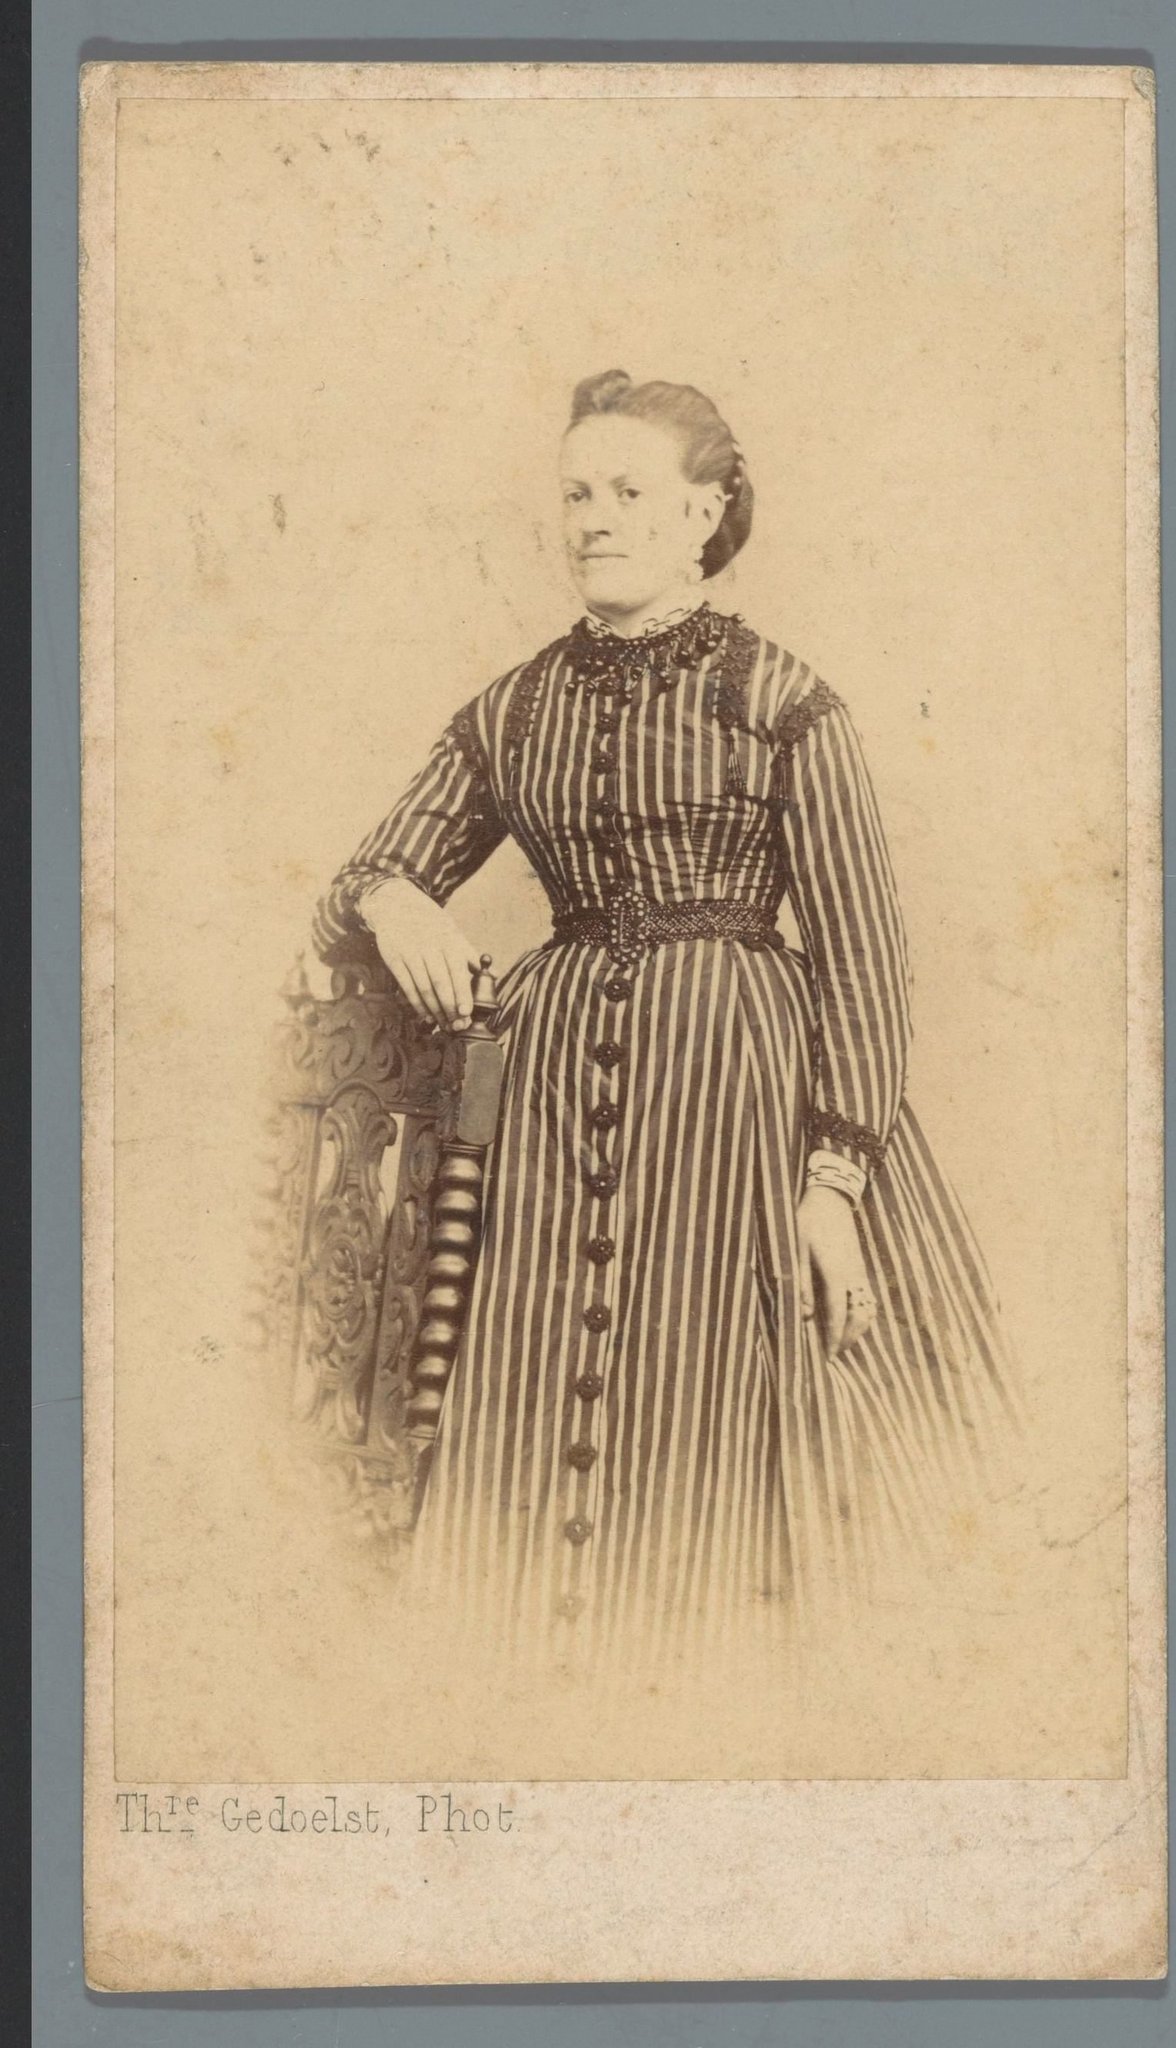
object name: photograph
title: Portret van Ch. Vankerckhoven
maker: théodore gedoelst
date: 1868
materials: cardboard, paper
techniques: albumen print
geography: leuven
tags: adult woman, historical persons, louvain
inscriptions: inscription: ‘À mon cousin Jh./ Vankerckhoven/ Louvain le 15 fev. 1868/ Ch.Vankerckhoven’, inscription: ‘Thre Gedoelst, Phot.’, inscription: ‘Atlier de Photographie./ Thre Gedoelst,/ Rue de Namur, 99./ Louvain’